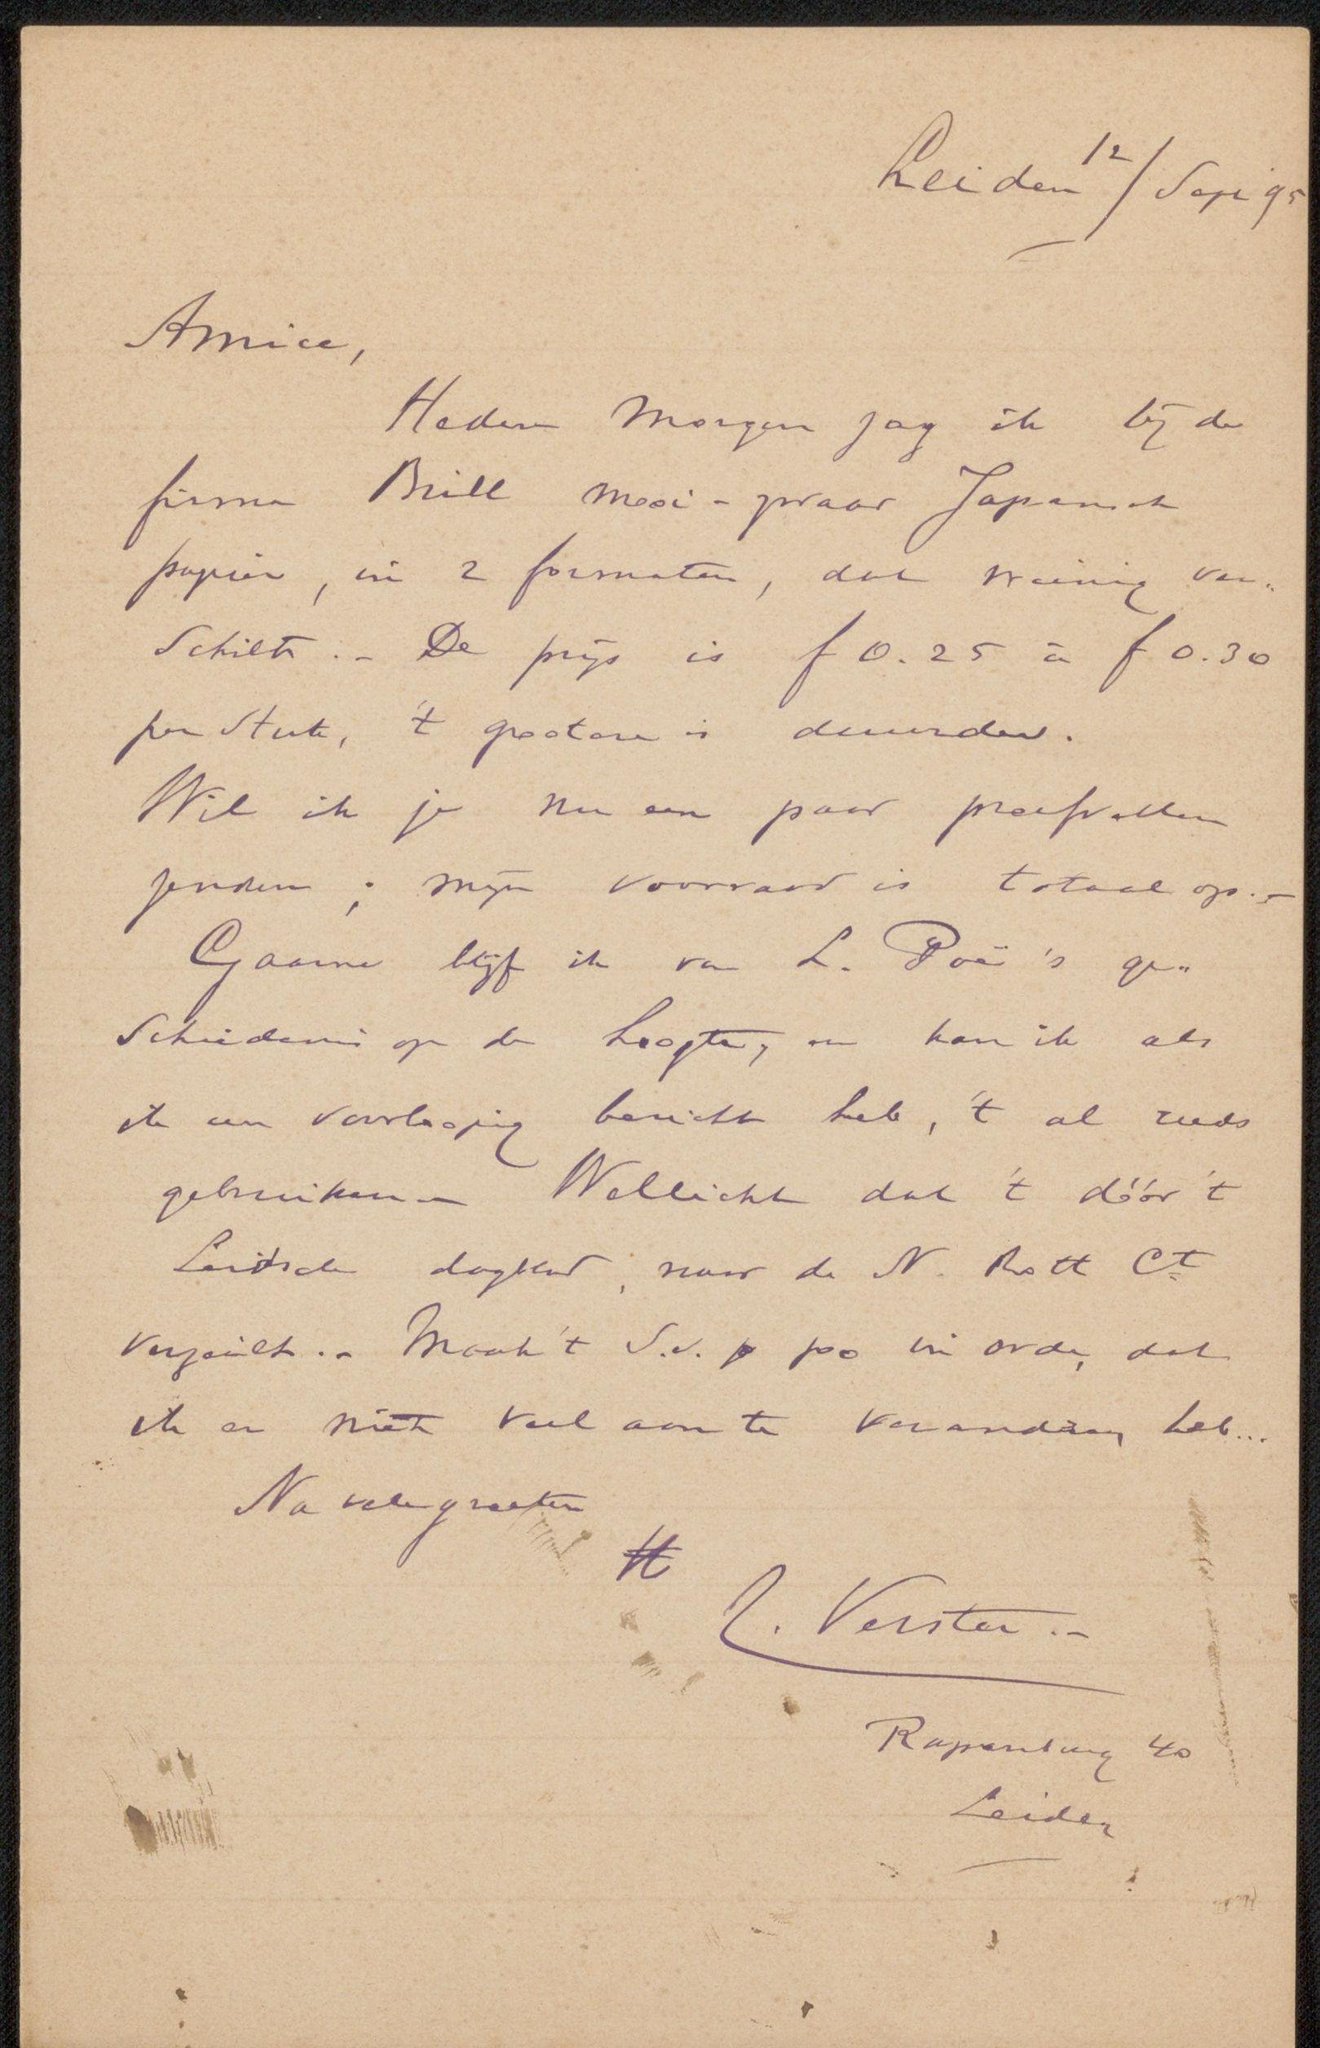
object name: letter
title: Brief aan Philip Zilcken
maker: cees verster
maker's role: conservator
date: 1895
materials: ink, paper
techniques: pen, writing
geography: leiden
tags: paris, lugné-poe, the hague, draughtsman, philip zilcken, money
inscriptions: collector's mark: ‘RPK’